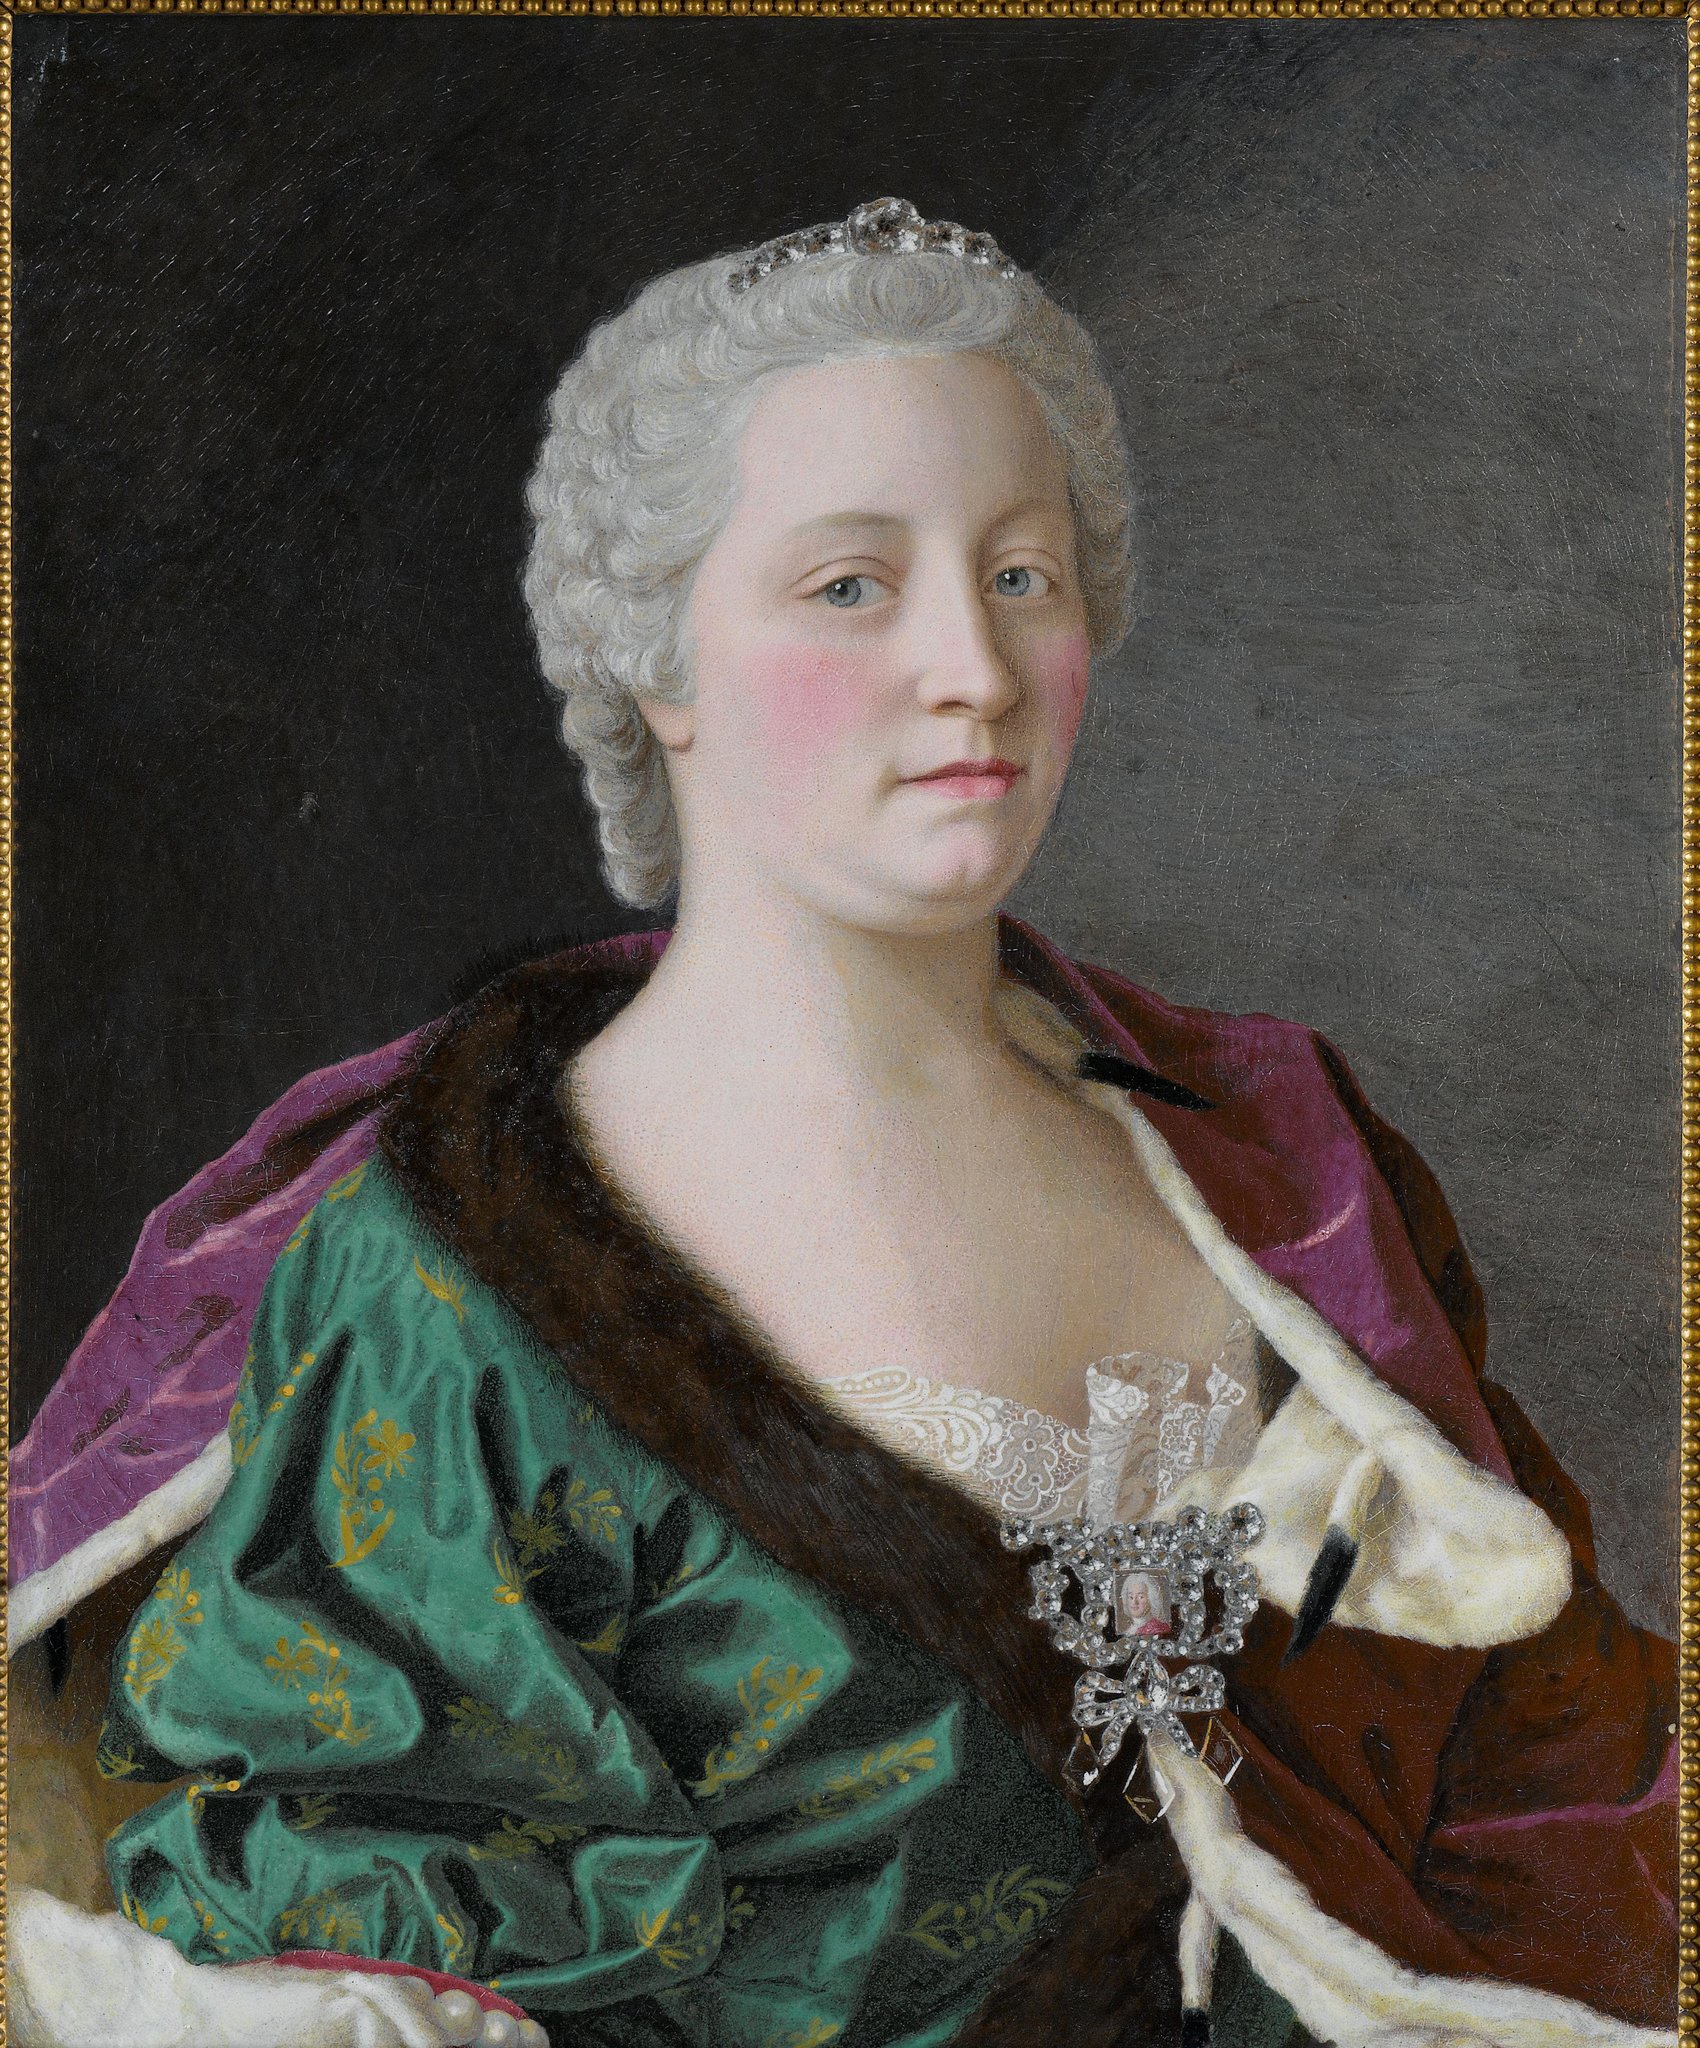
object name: painting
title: Maria Theresa, Archduchess of Austria, Queen of Hungary and Bohemia, and Holy Roman Empress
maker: jean-etienne liotard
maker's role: painter, print maker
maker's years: 1702-1789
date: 1747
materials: copper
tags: vienna, maria theresia (rooms-duits keizerin), historical persons - bb - woman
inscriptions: inscription: ‘Marie Therese Imperatrice Reine de hongrie & de Boheme, peinte par Liotard de Geneve a Lion 1747’, : ‘2e essai’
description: Liotard made this enamel during a visit to Lyon, basing it on one of several portraits of the sovereign he had earlier done in Vienna. He was particularly proud of the ‘brilliance’ of the hard gem-like surface and colouring. It is one of the largest enamel paintings ever made, and the technique gave Liotard some difficulty: an inscription on the back records that this was the ‘second attempt.’